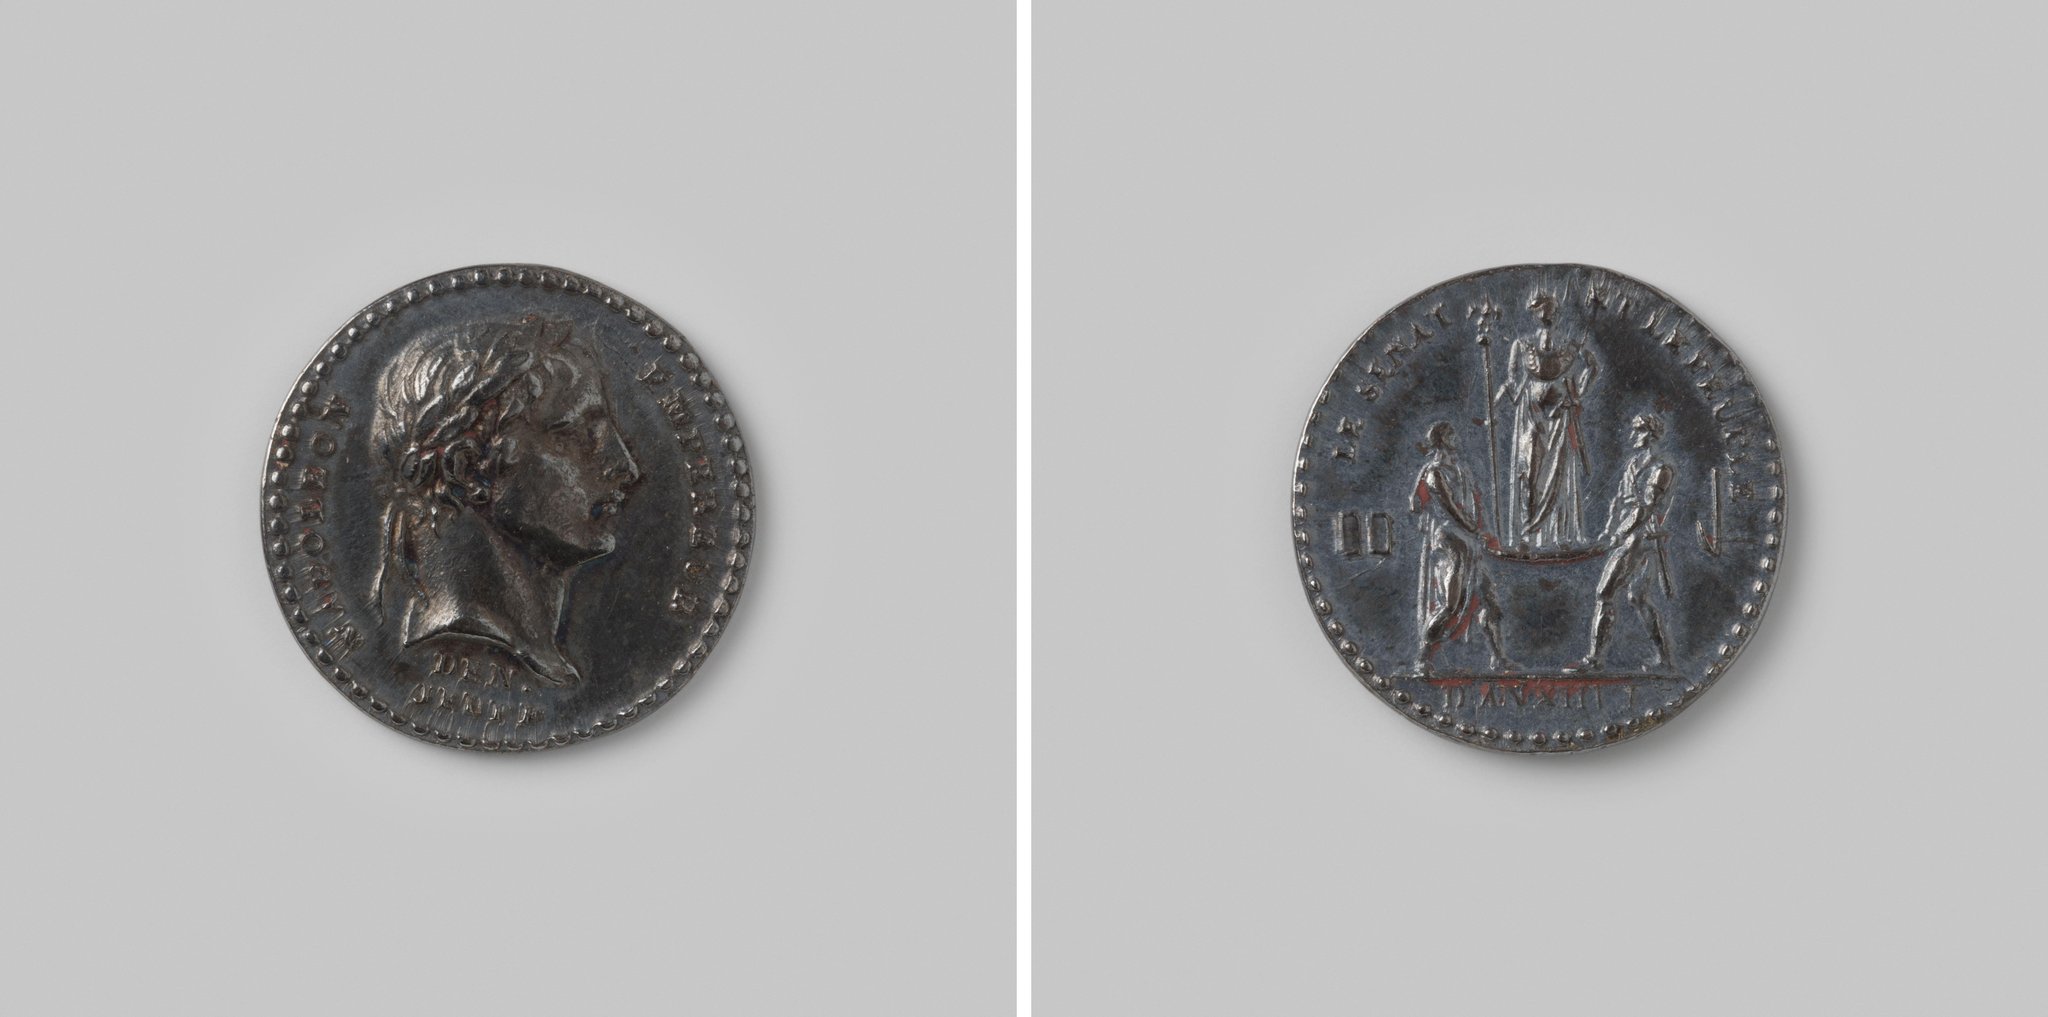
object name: history medal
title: Frankrijk verheven tot keizerrijk onder Keizer Napoleon 1804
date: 1804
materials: silver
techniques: striking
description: Kleine zilveren penning, op de voorzijde het portret van Napoleon naar rechts met omschrift, op de keerzijde twee manen die een derde, met zwaard, scepter en banier, op een schild dragen, met omschrift en afsnedetekst.